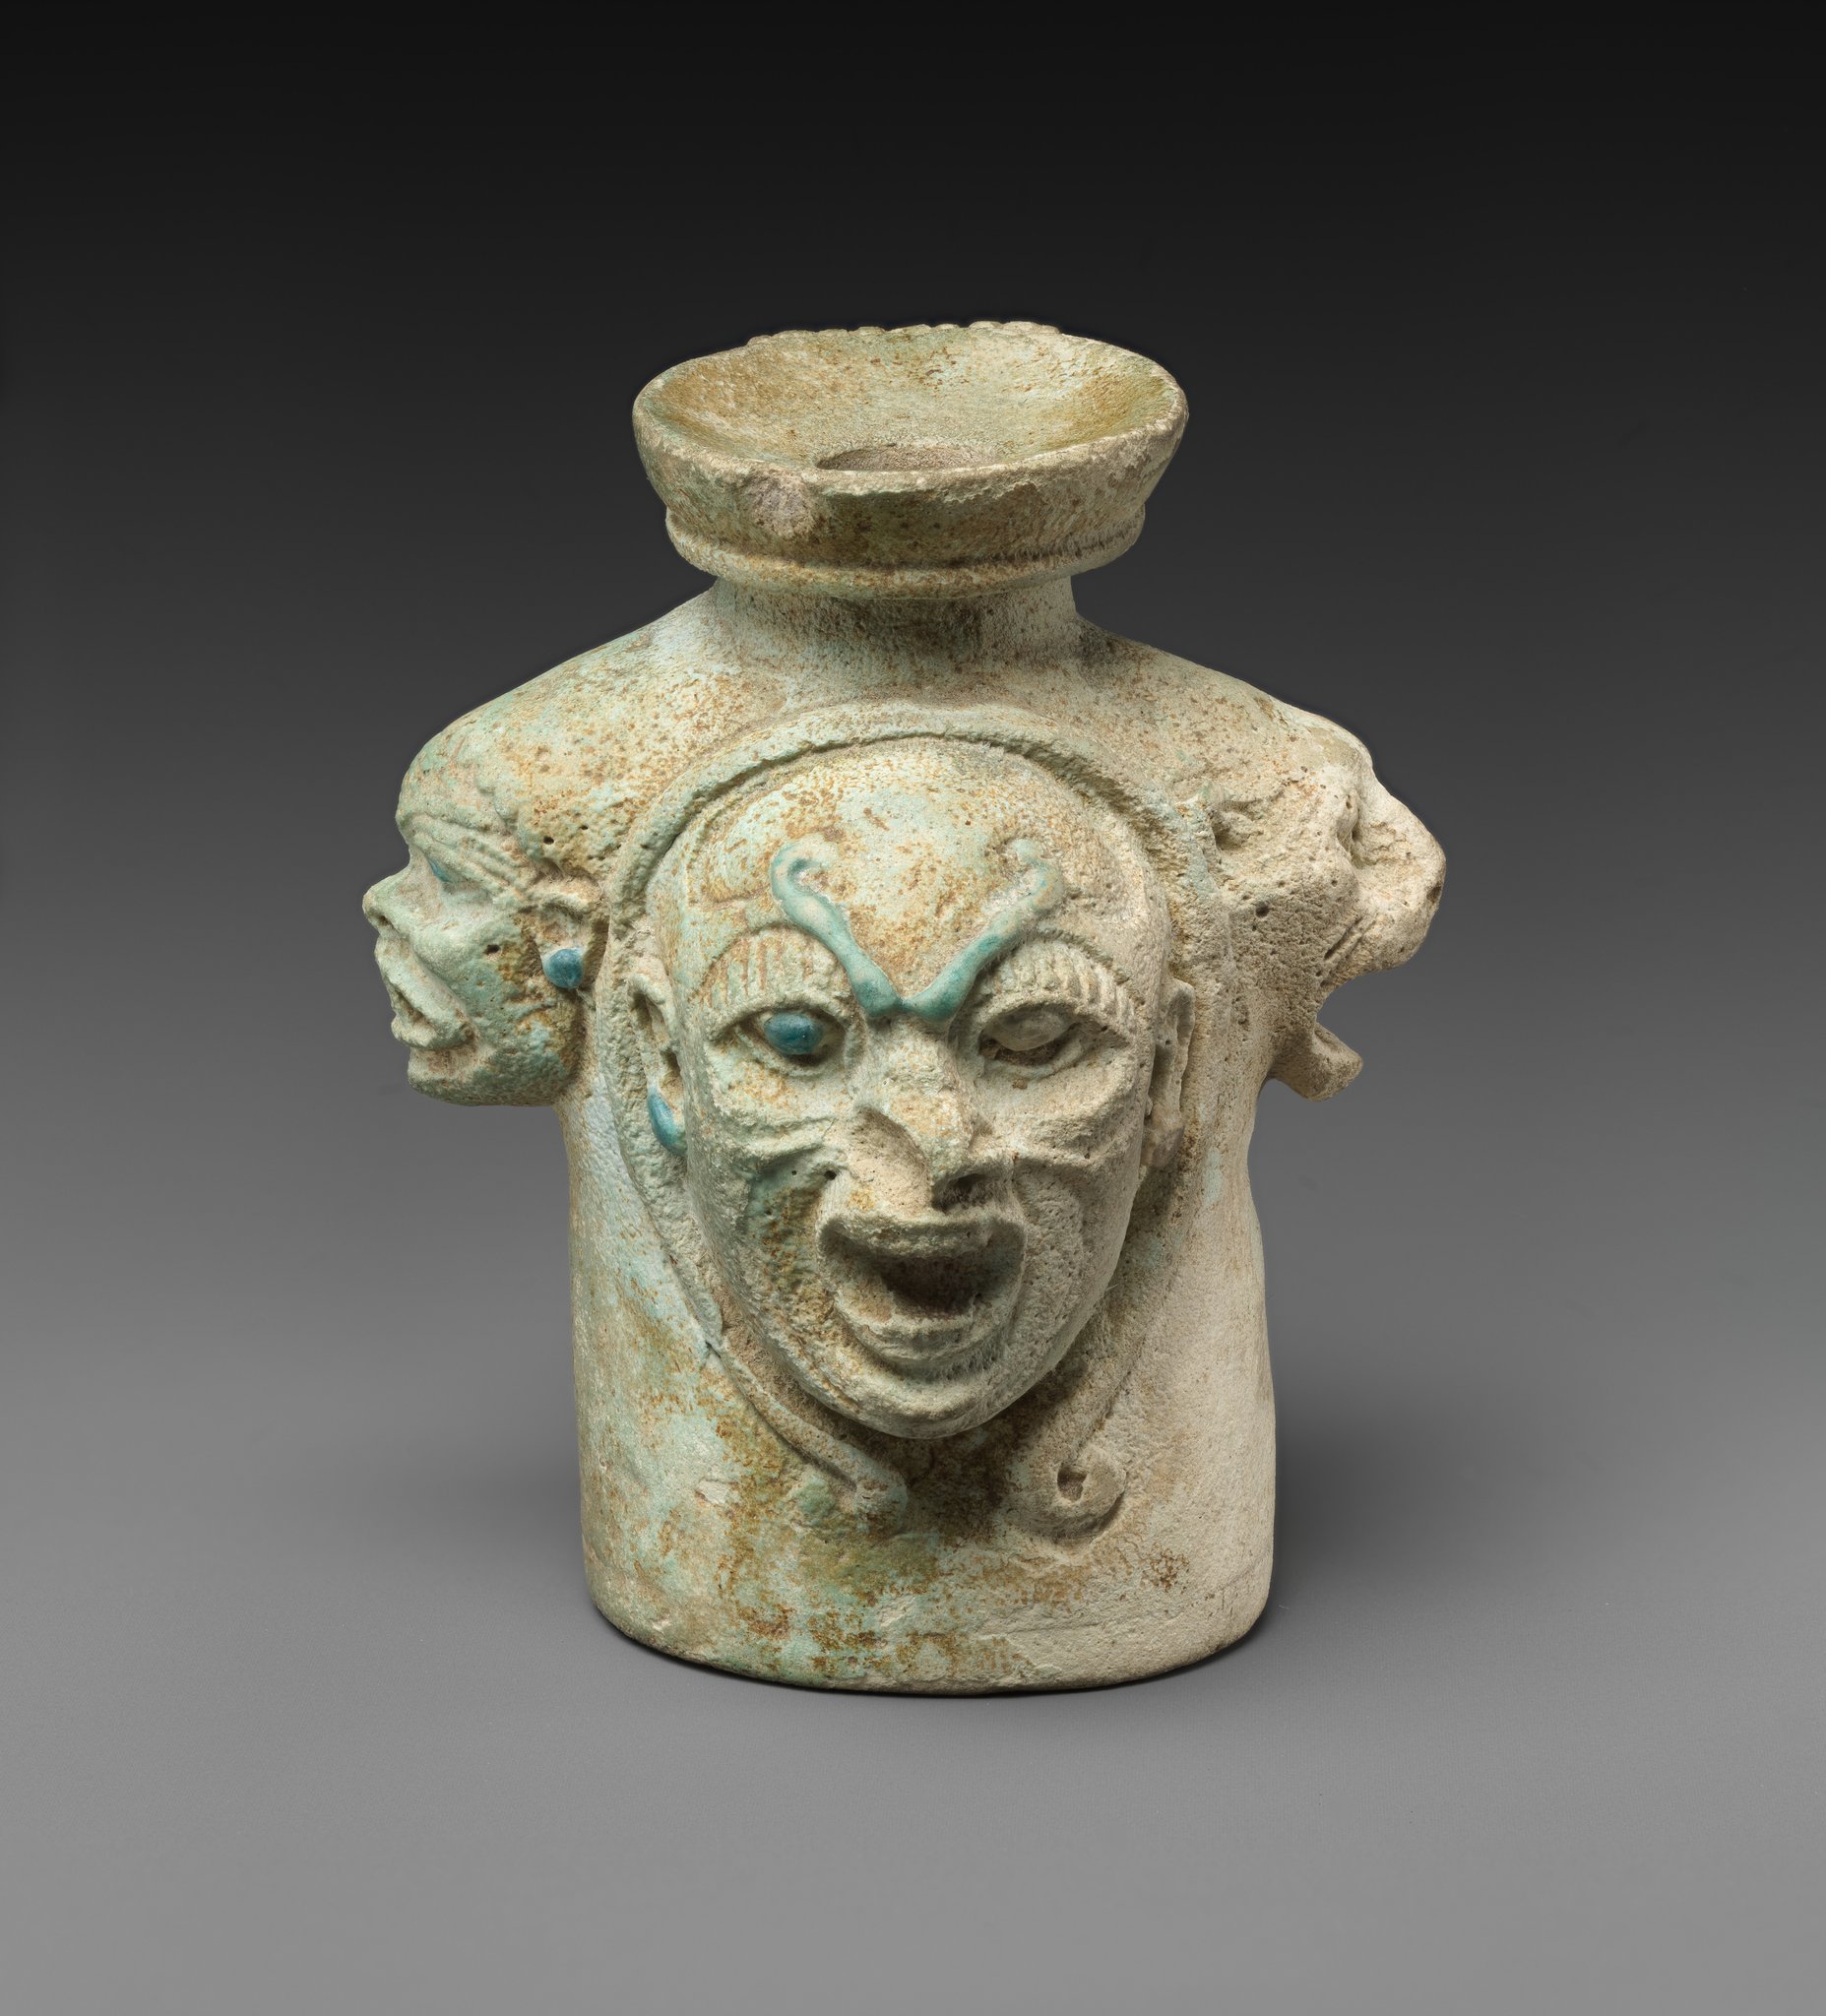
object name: aryballos in the form of four head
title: Faience aryballos (perfume vase) in the form of four heads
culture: east greek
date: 534-501 BCE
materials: faience